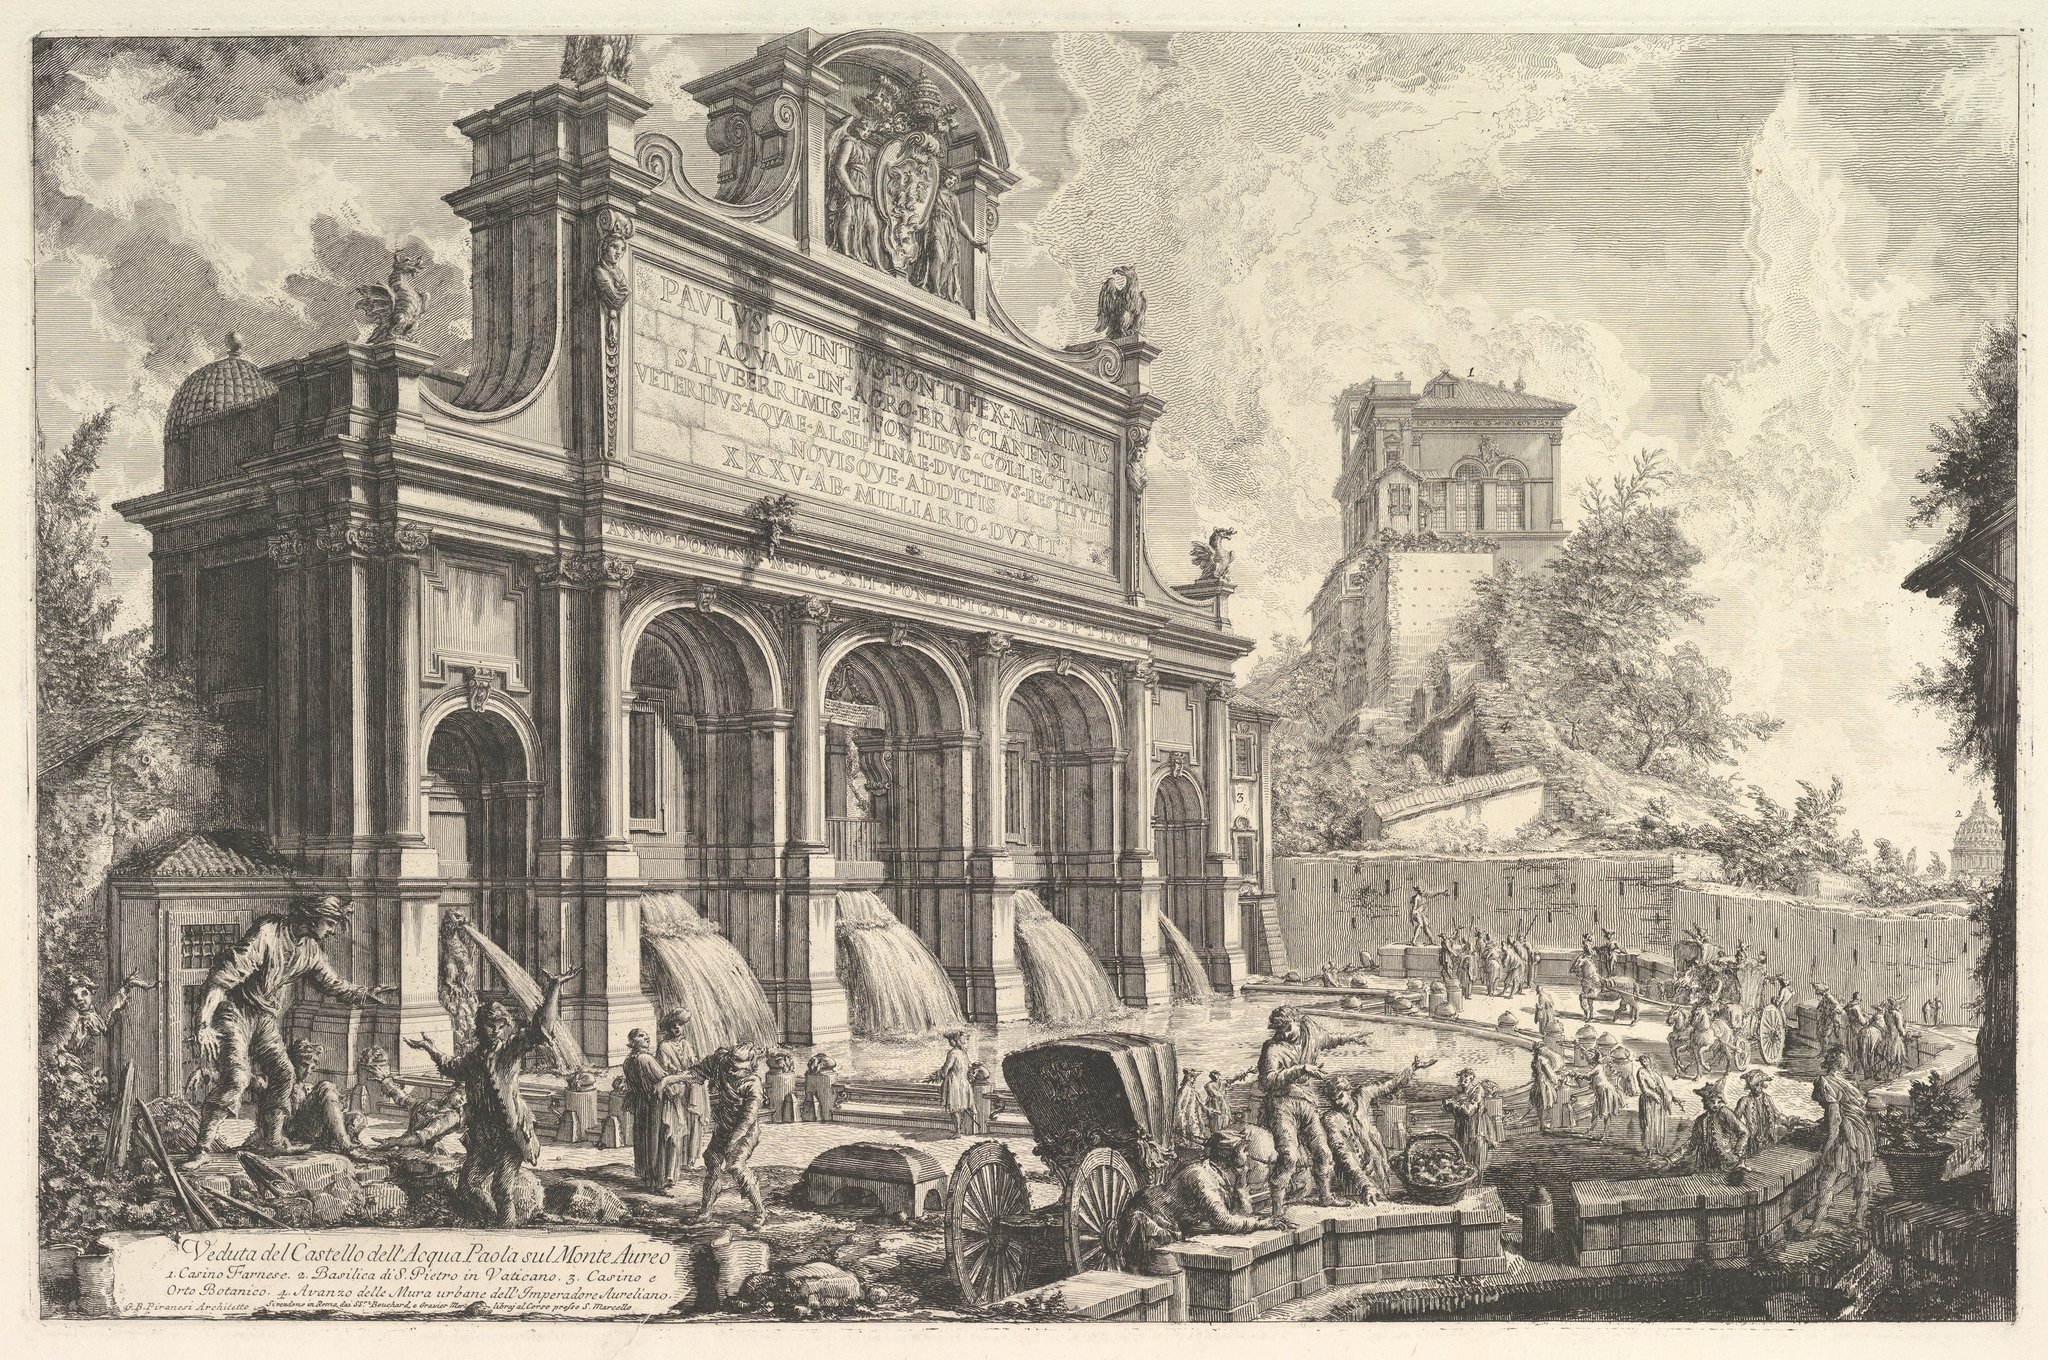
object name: print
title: View of the Fountainhead of the Acqua Paola on Monte Aureo, from Vedute di Roma (Roman Views)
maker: giovanni battista piranesi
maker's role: artist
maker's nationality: italian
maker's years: 1720-1778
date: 1751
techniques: etching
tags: human figures,fountains,rome